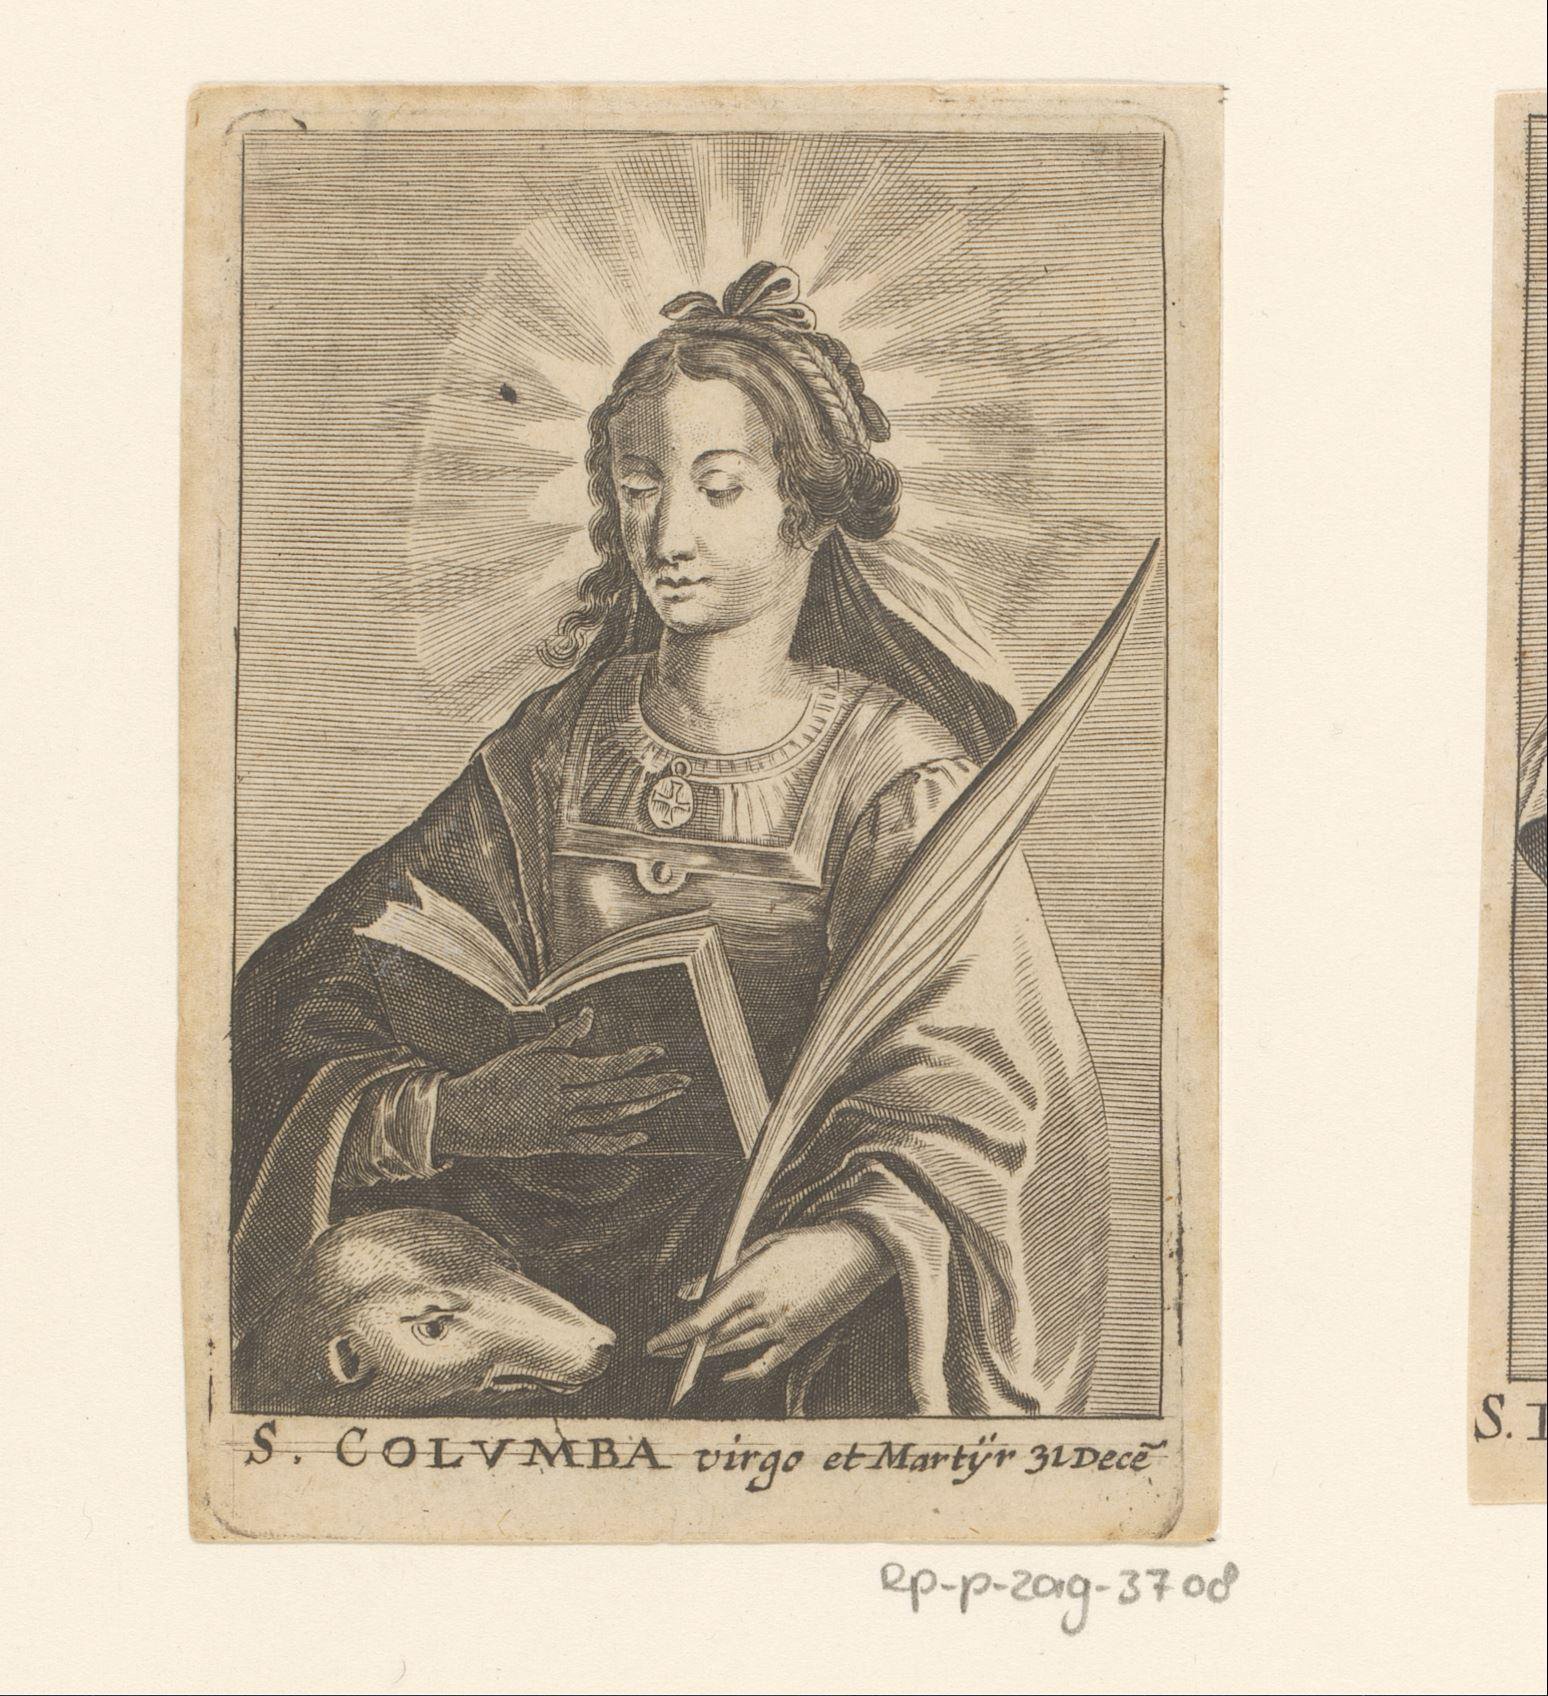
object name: print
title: H. Columba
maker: Anonymous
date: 1600-1699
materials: paper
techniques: engraving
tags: female saints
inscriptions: collector's mark: Lugt 2228